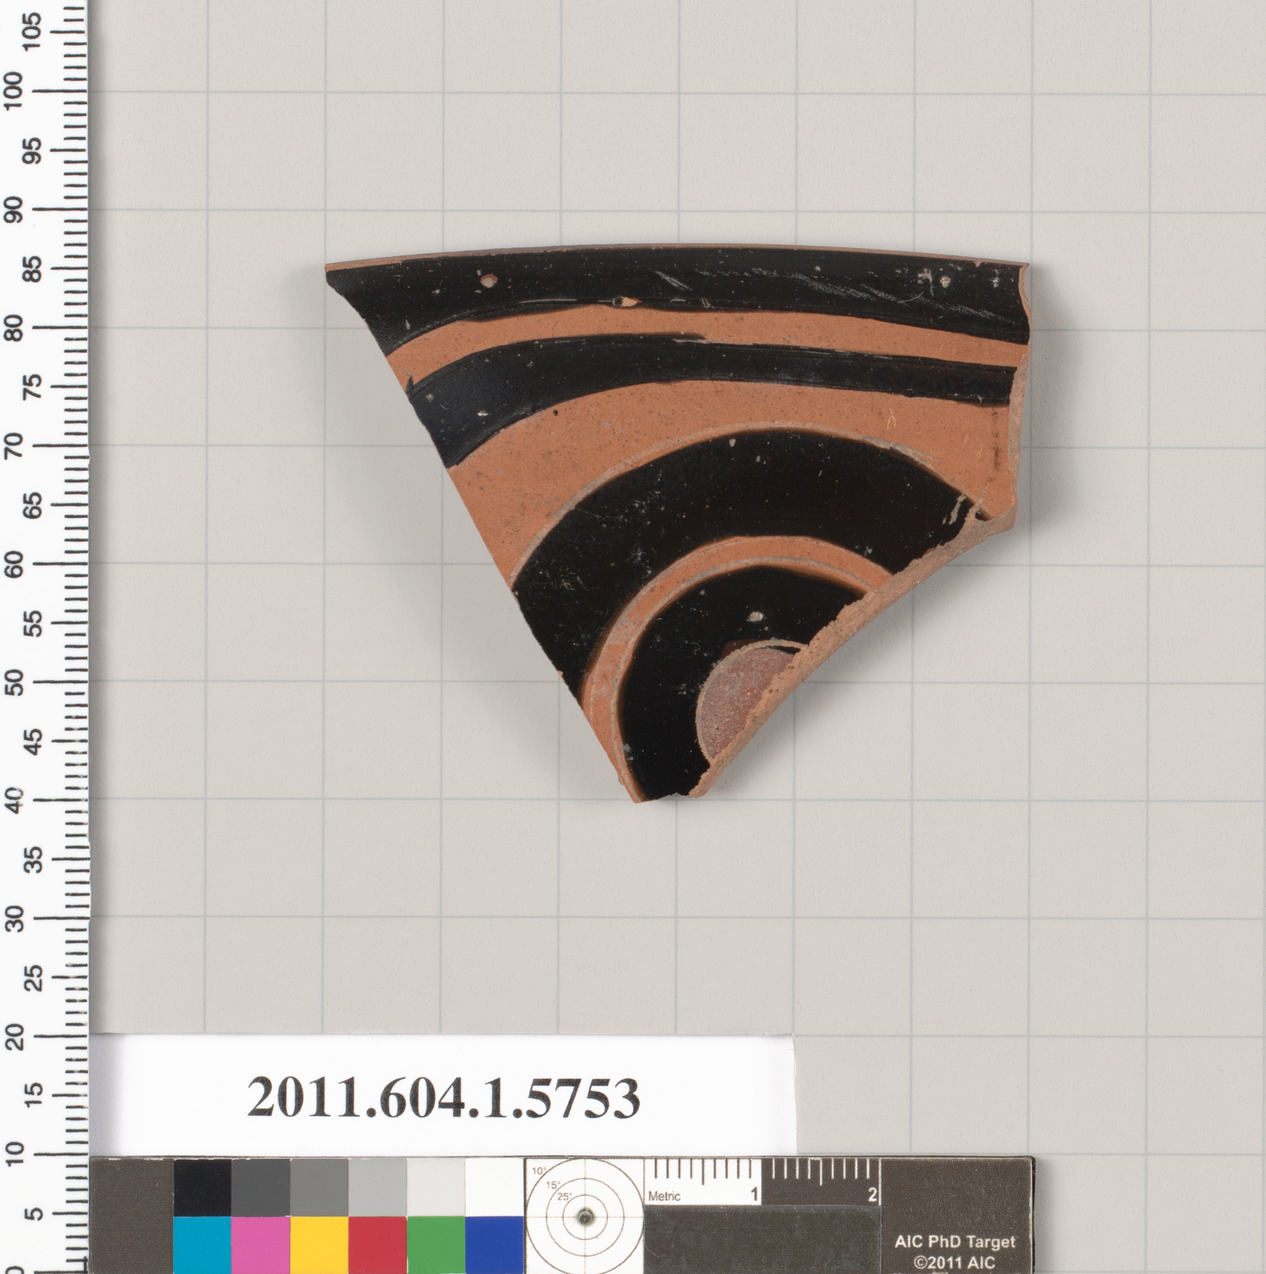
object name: kylix fragment, eye cup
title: Terracotta rim fragment of a kylix: eye-cup (drinking cup)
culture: greek, attic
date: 525-515 BCE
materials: terracotta